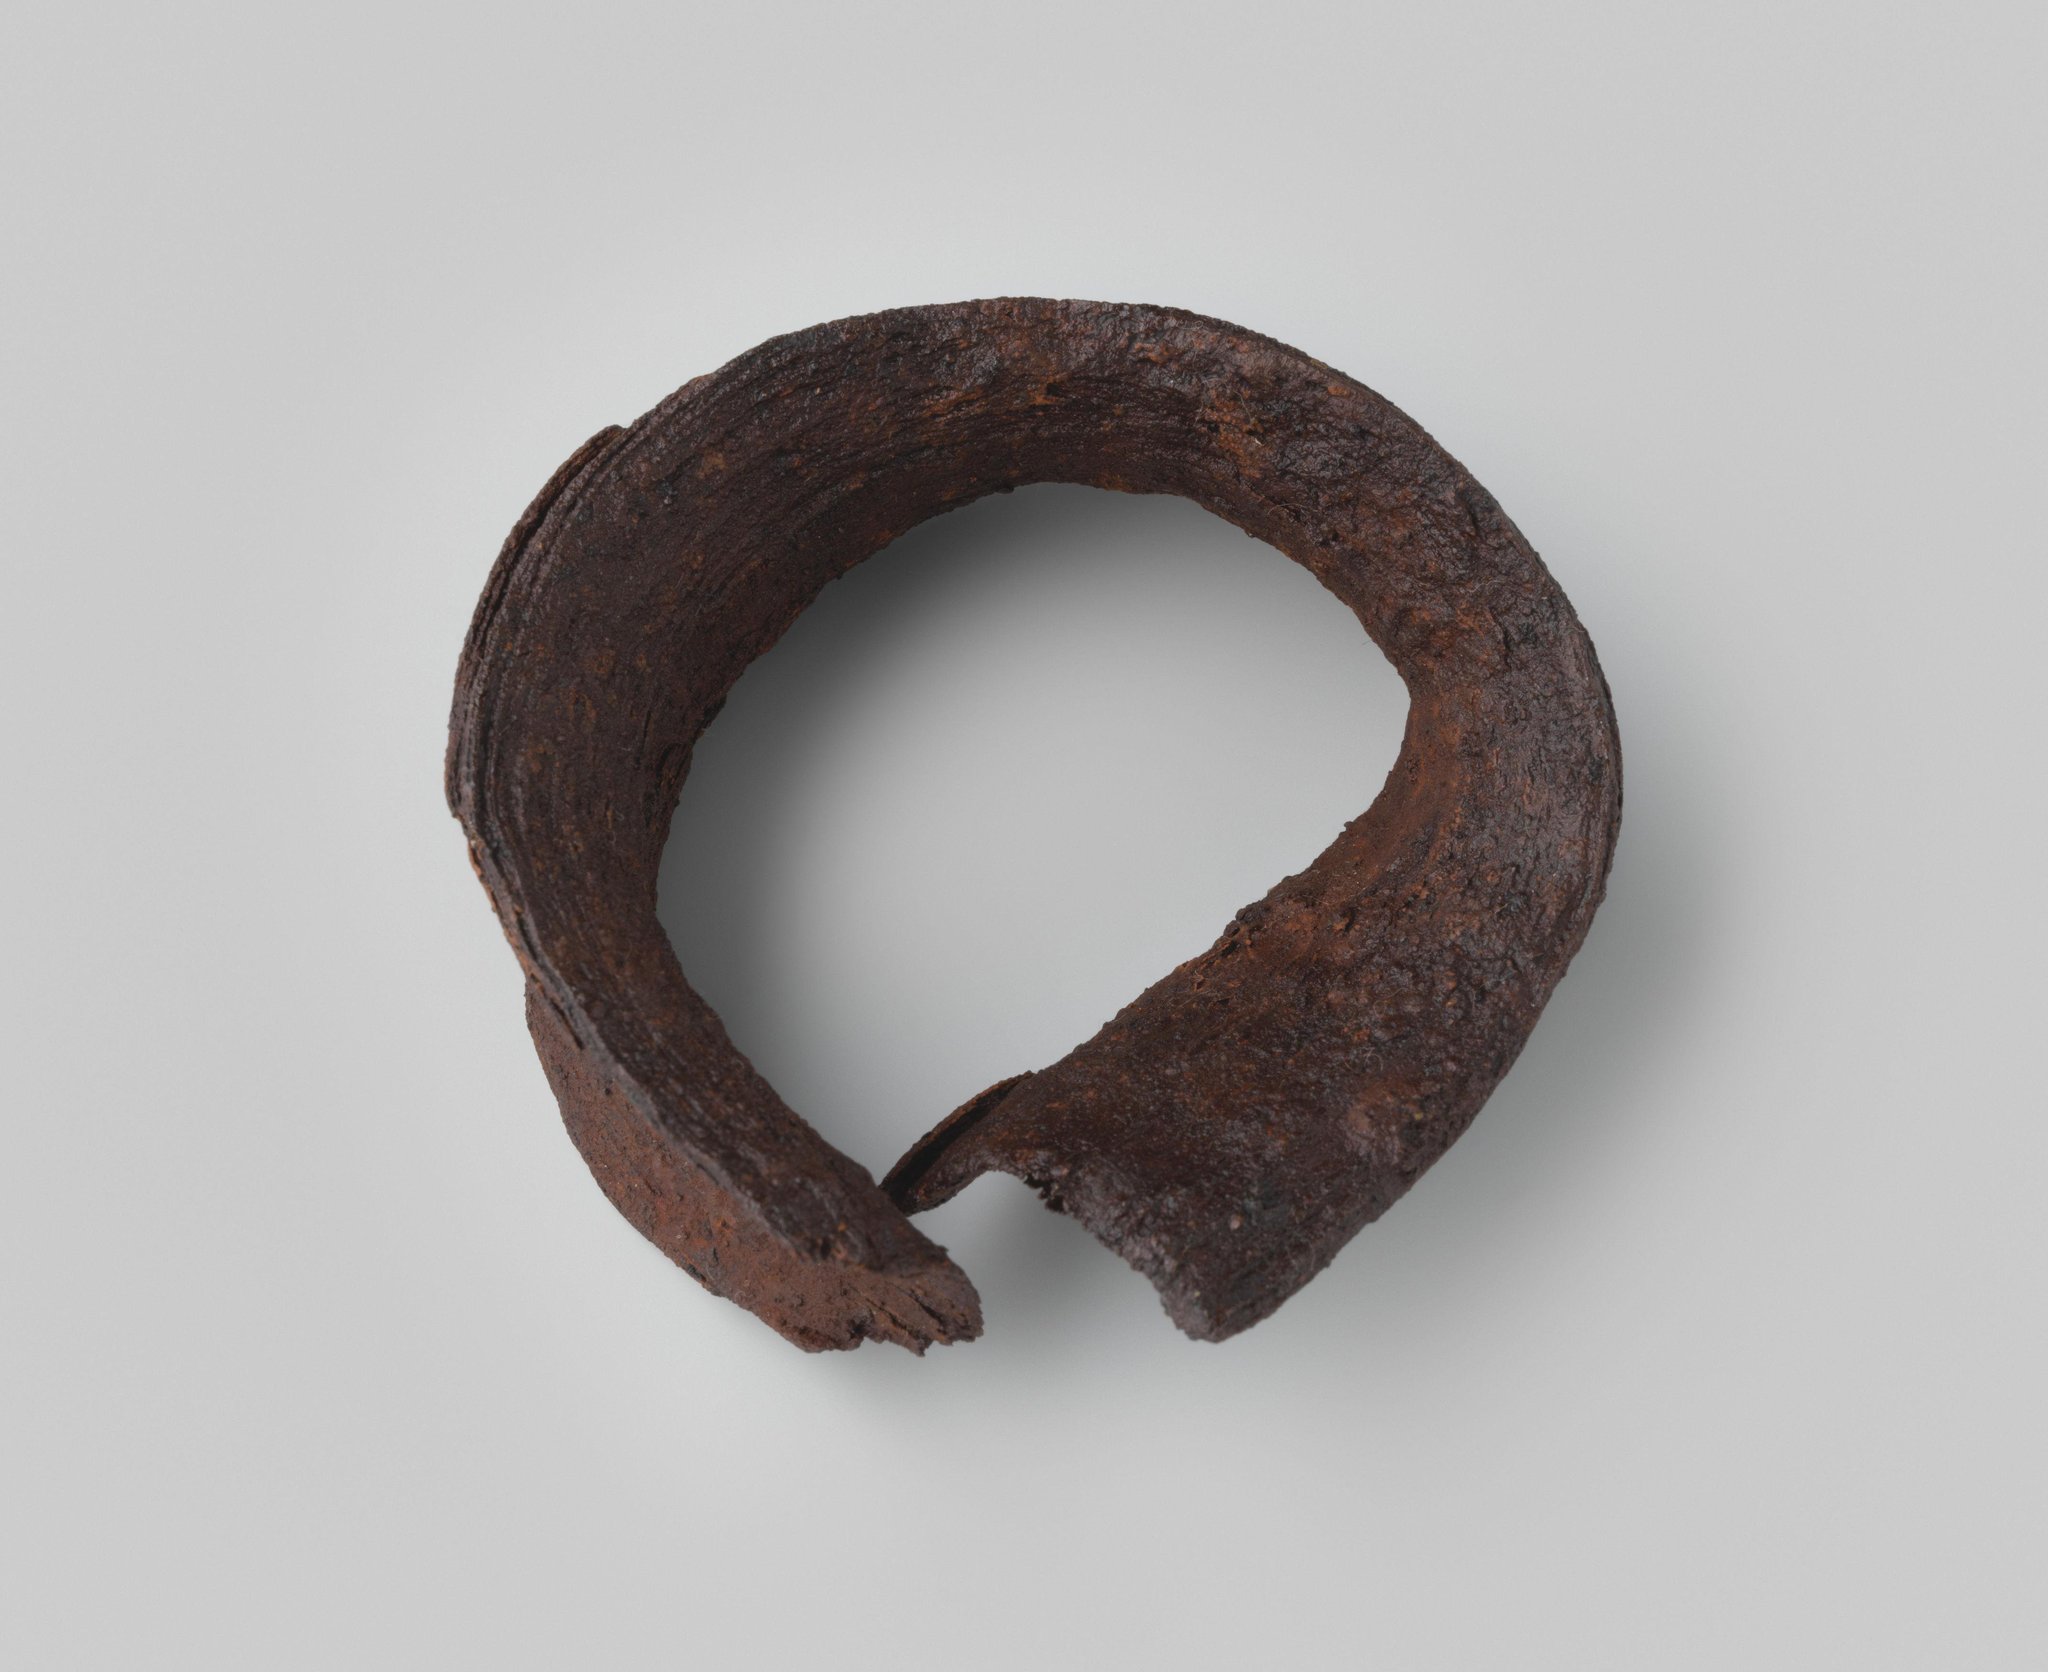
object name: kous bevestigingsmiddel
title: Kous uit het wrak van de Oost-Indiëvaarder Hollandia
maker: Anonymous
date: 1700-1743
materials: iron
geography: netherlands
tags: verenigde oostindische compagnie, hollandia (schip), annet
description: Rope thimble, eroded; band, looped, oval outline, concave outside.